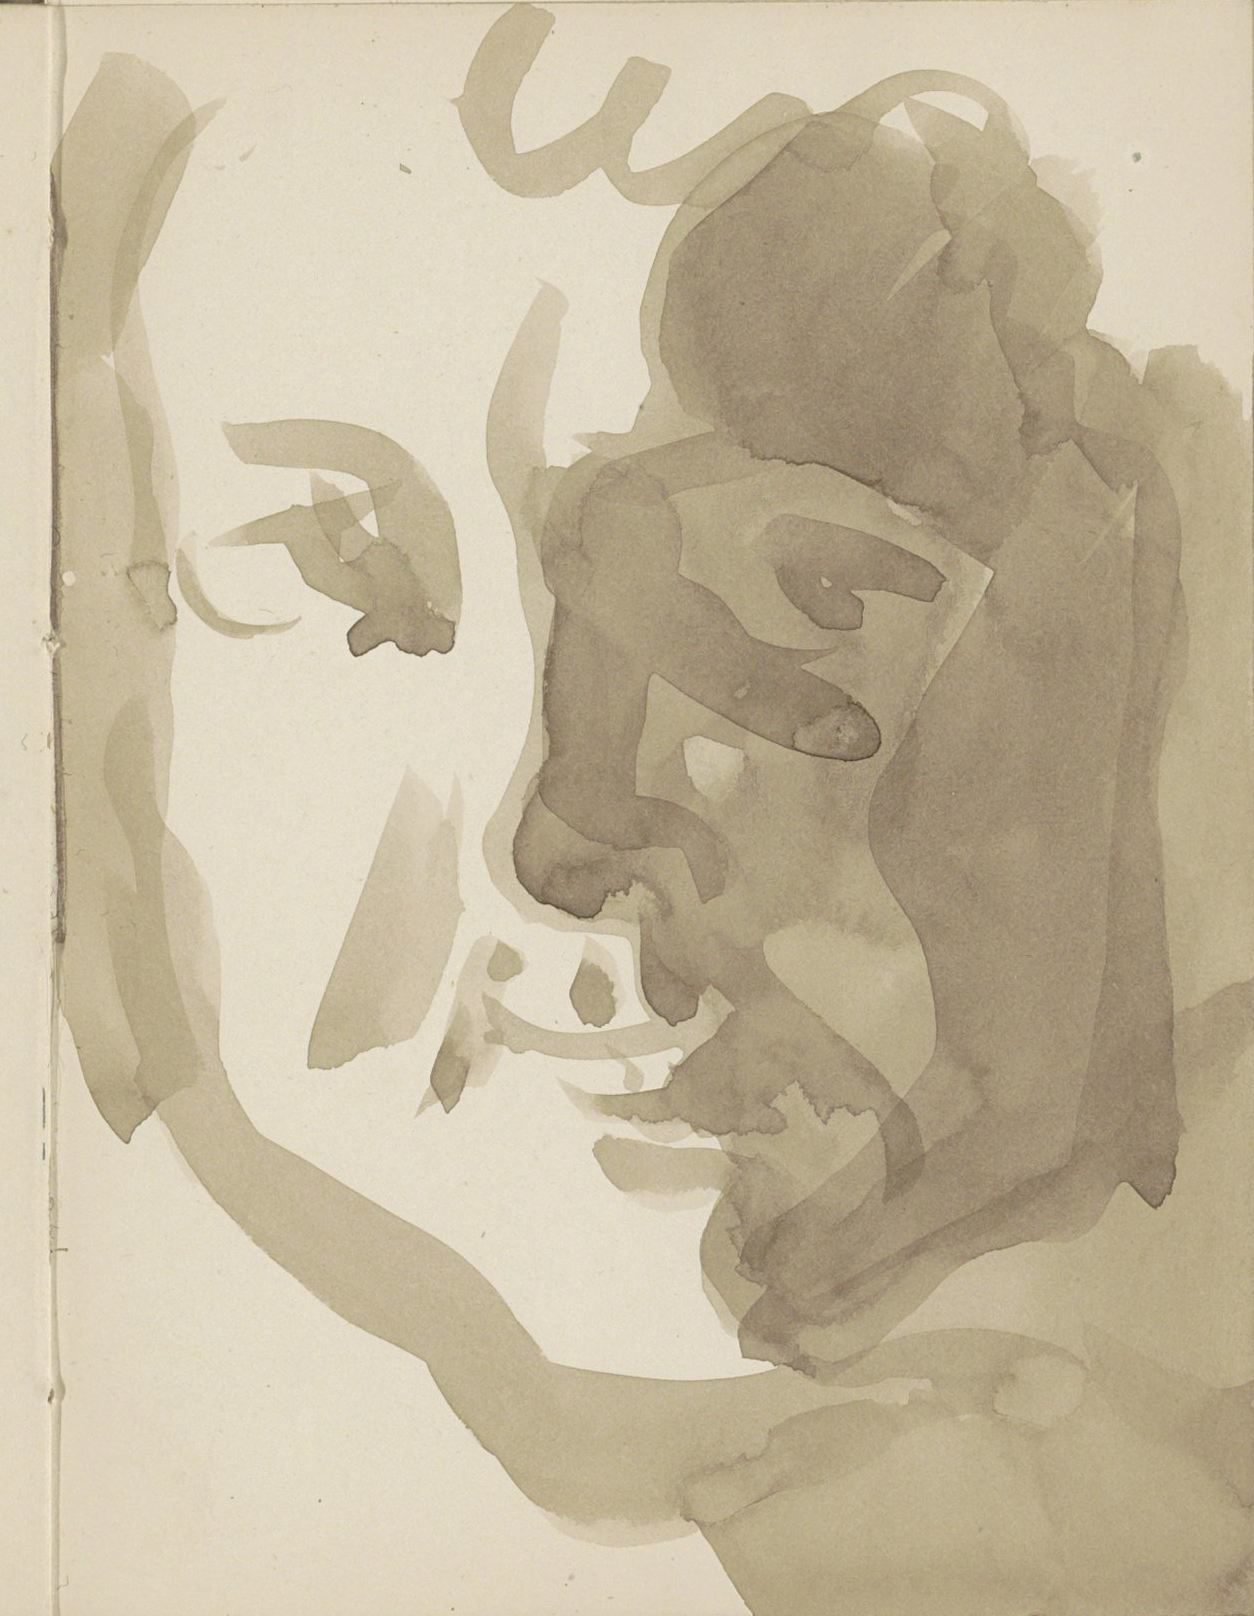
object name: sketchbook leaf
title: Kop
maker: reijer stolk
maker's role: draughtsman, print maker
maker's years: 1896-1945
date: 1906-1945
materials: paper, watercolor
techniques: brush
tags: head (human)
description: Blad 11 recto uit een schetsboek met 69 bladen.